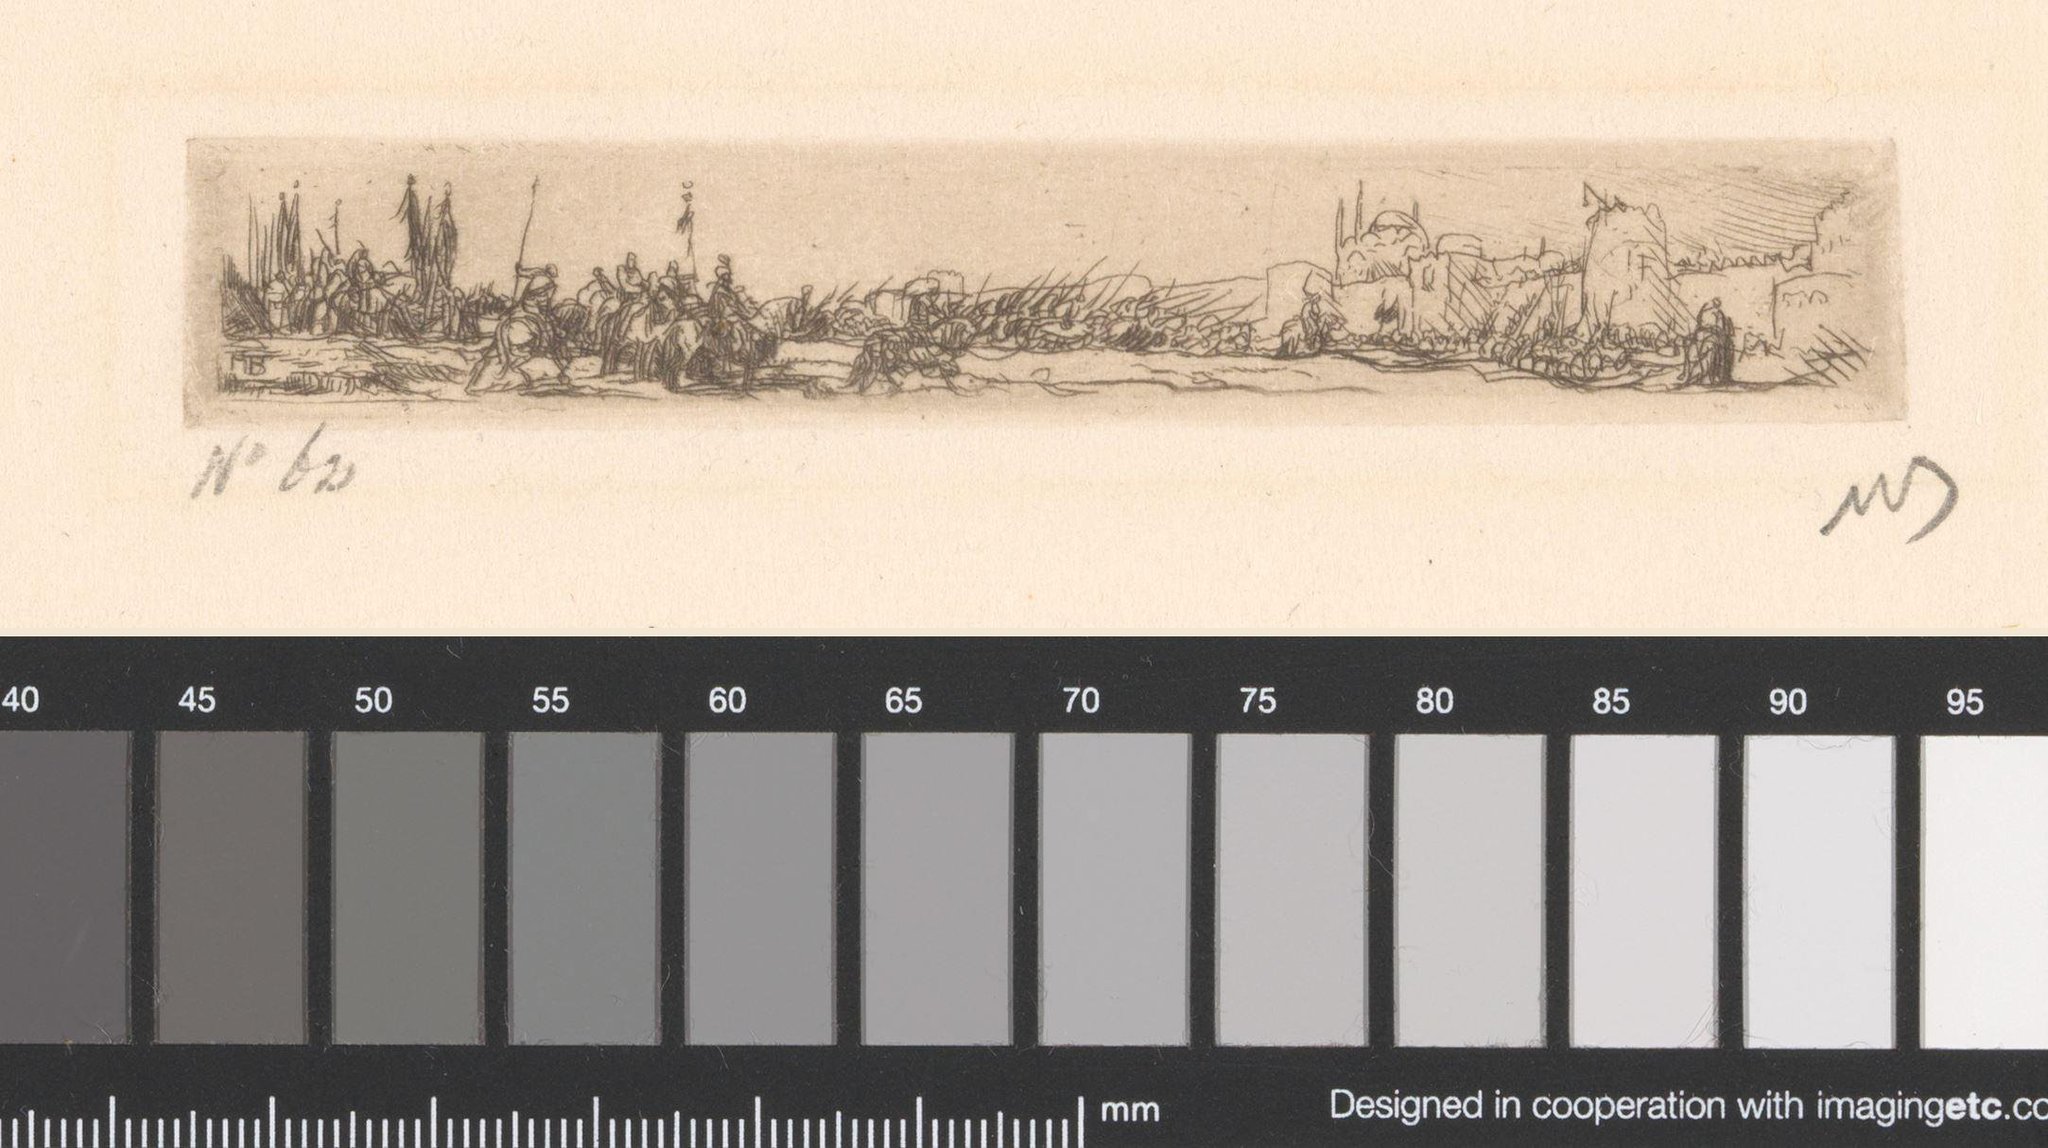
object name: print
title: Beleg van Constantinopel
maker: marius bauer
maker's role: draughtsman, print maker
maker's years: 1867-1932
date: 1902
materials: paper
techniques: etching, intaglio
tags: riding a horse, ass, or mule; rider, horseman, siege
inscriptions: collector's mark: Lugt 2228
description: Bewapende troepen op paarden bij de stadsmuren van Constantinopel.